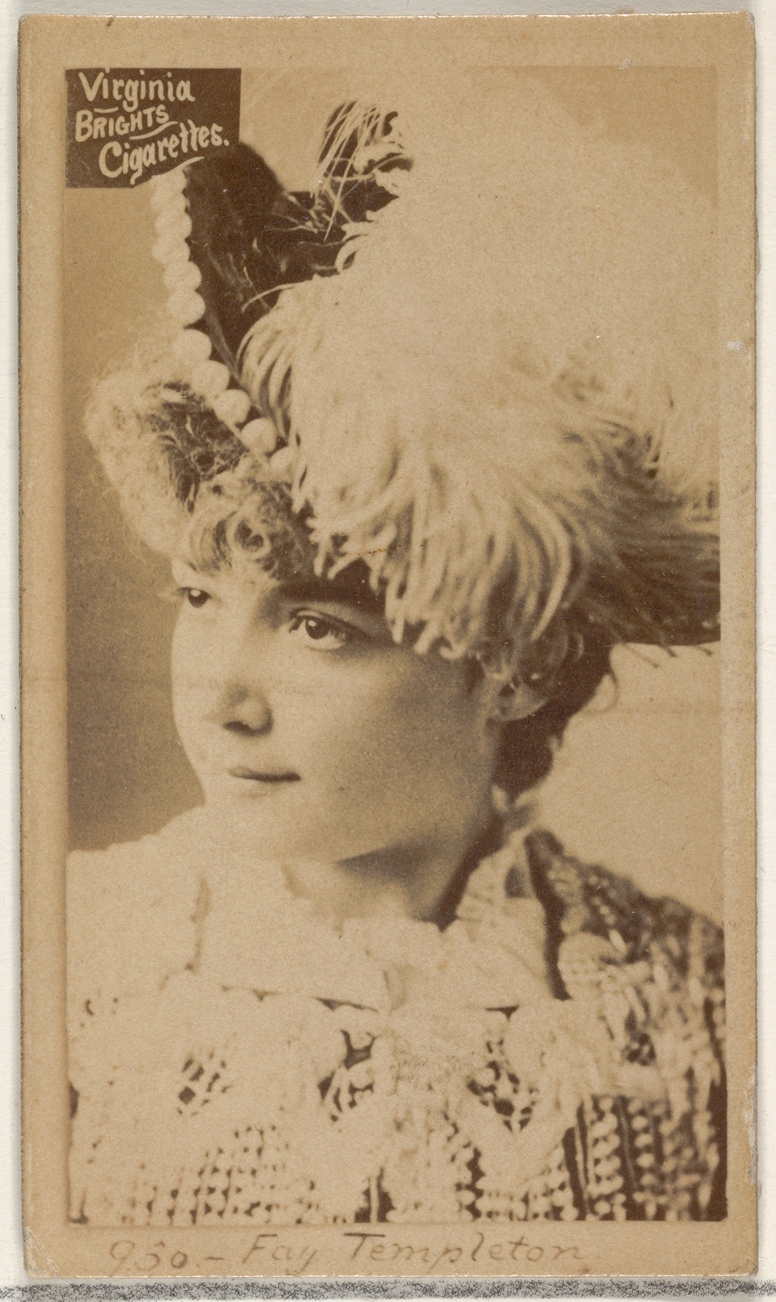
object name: photograph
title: Card 930, Fay Templeton, from the Actors and Actresses series (N45, Type 2) for Virginia Brights Cigarettes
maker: allen & ginter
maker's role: publisher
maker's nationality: american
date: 1888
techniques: albumen silver print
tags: portraits,women,actresses